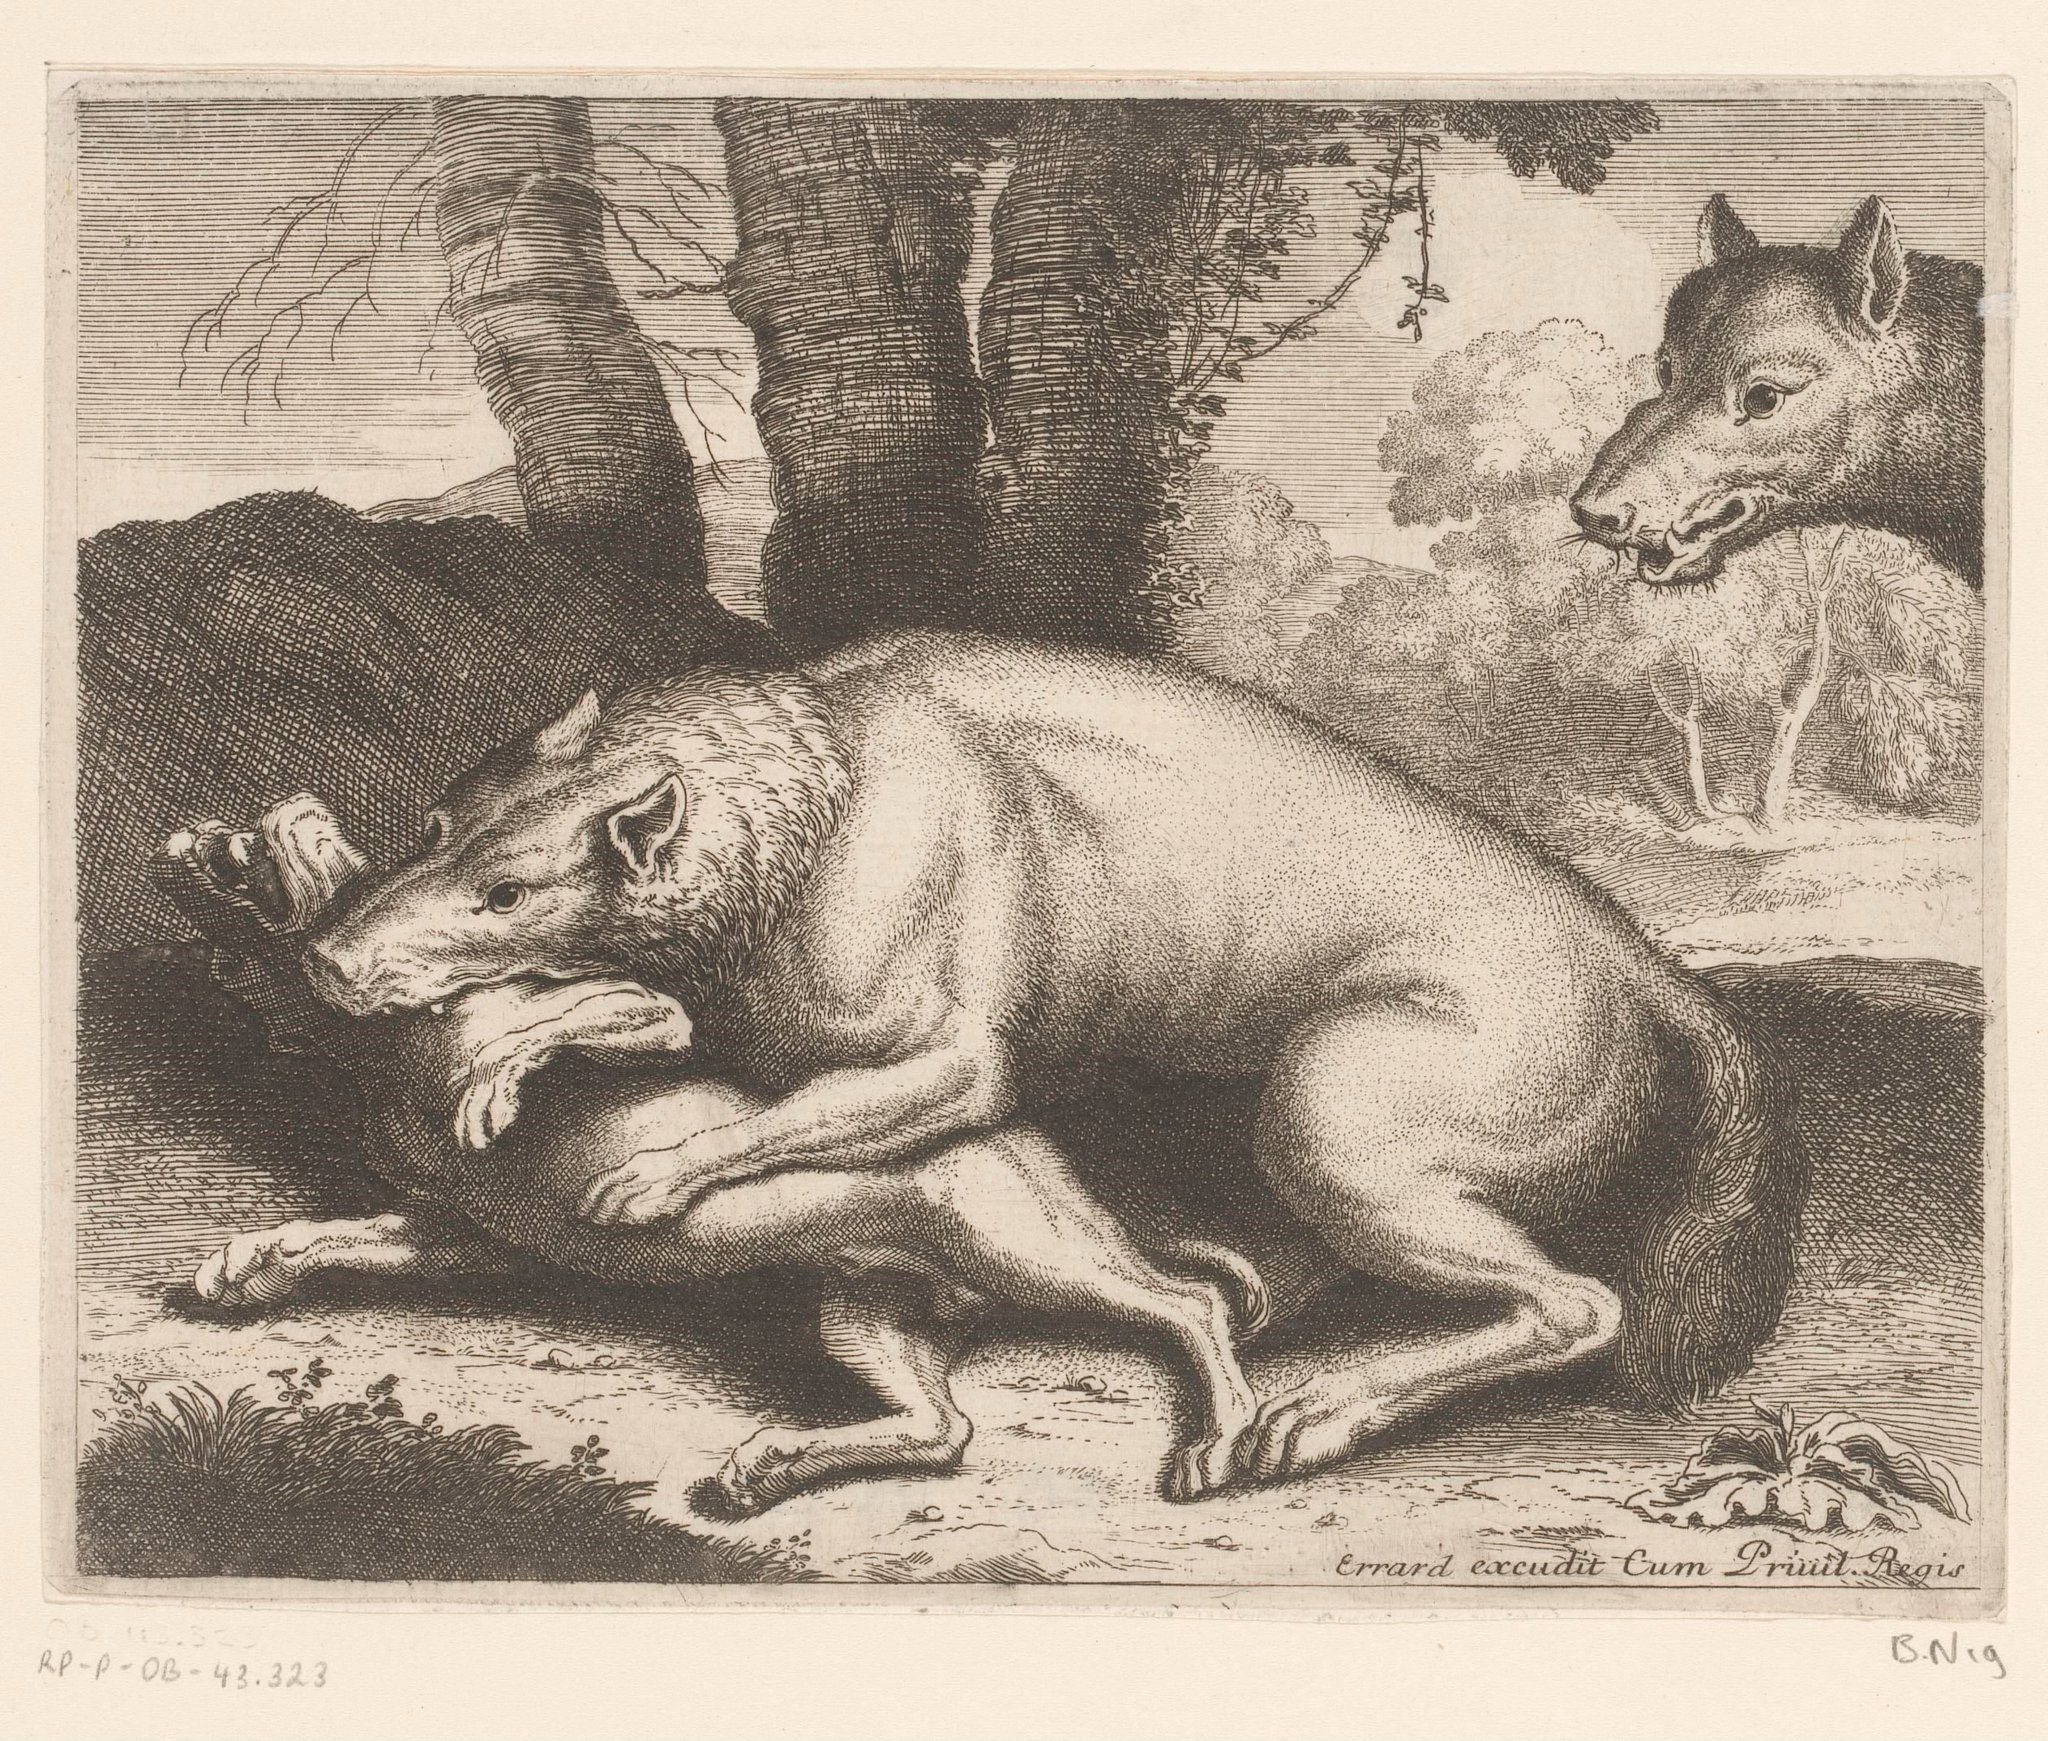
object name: print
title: Dierenserie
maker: charles ii errard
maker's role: print maker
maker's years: 1601-1689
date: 1616-1689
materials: paper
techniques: engraving, etching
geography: paris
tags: fighting, dog, beasts of prey, predatory animals: wolf